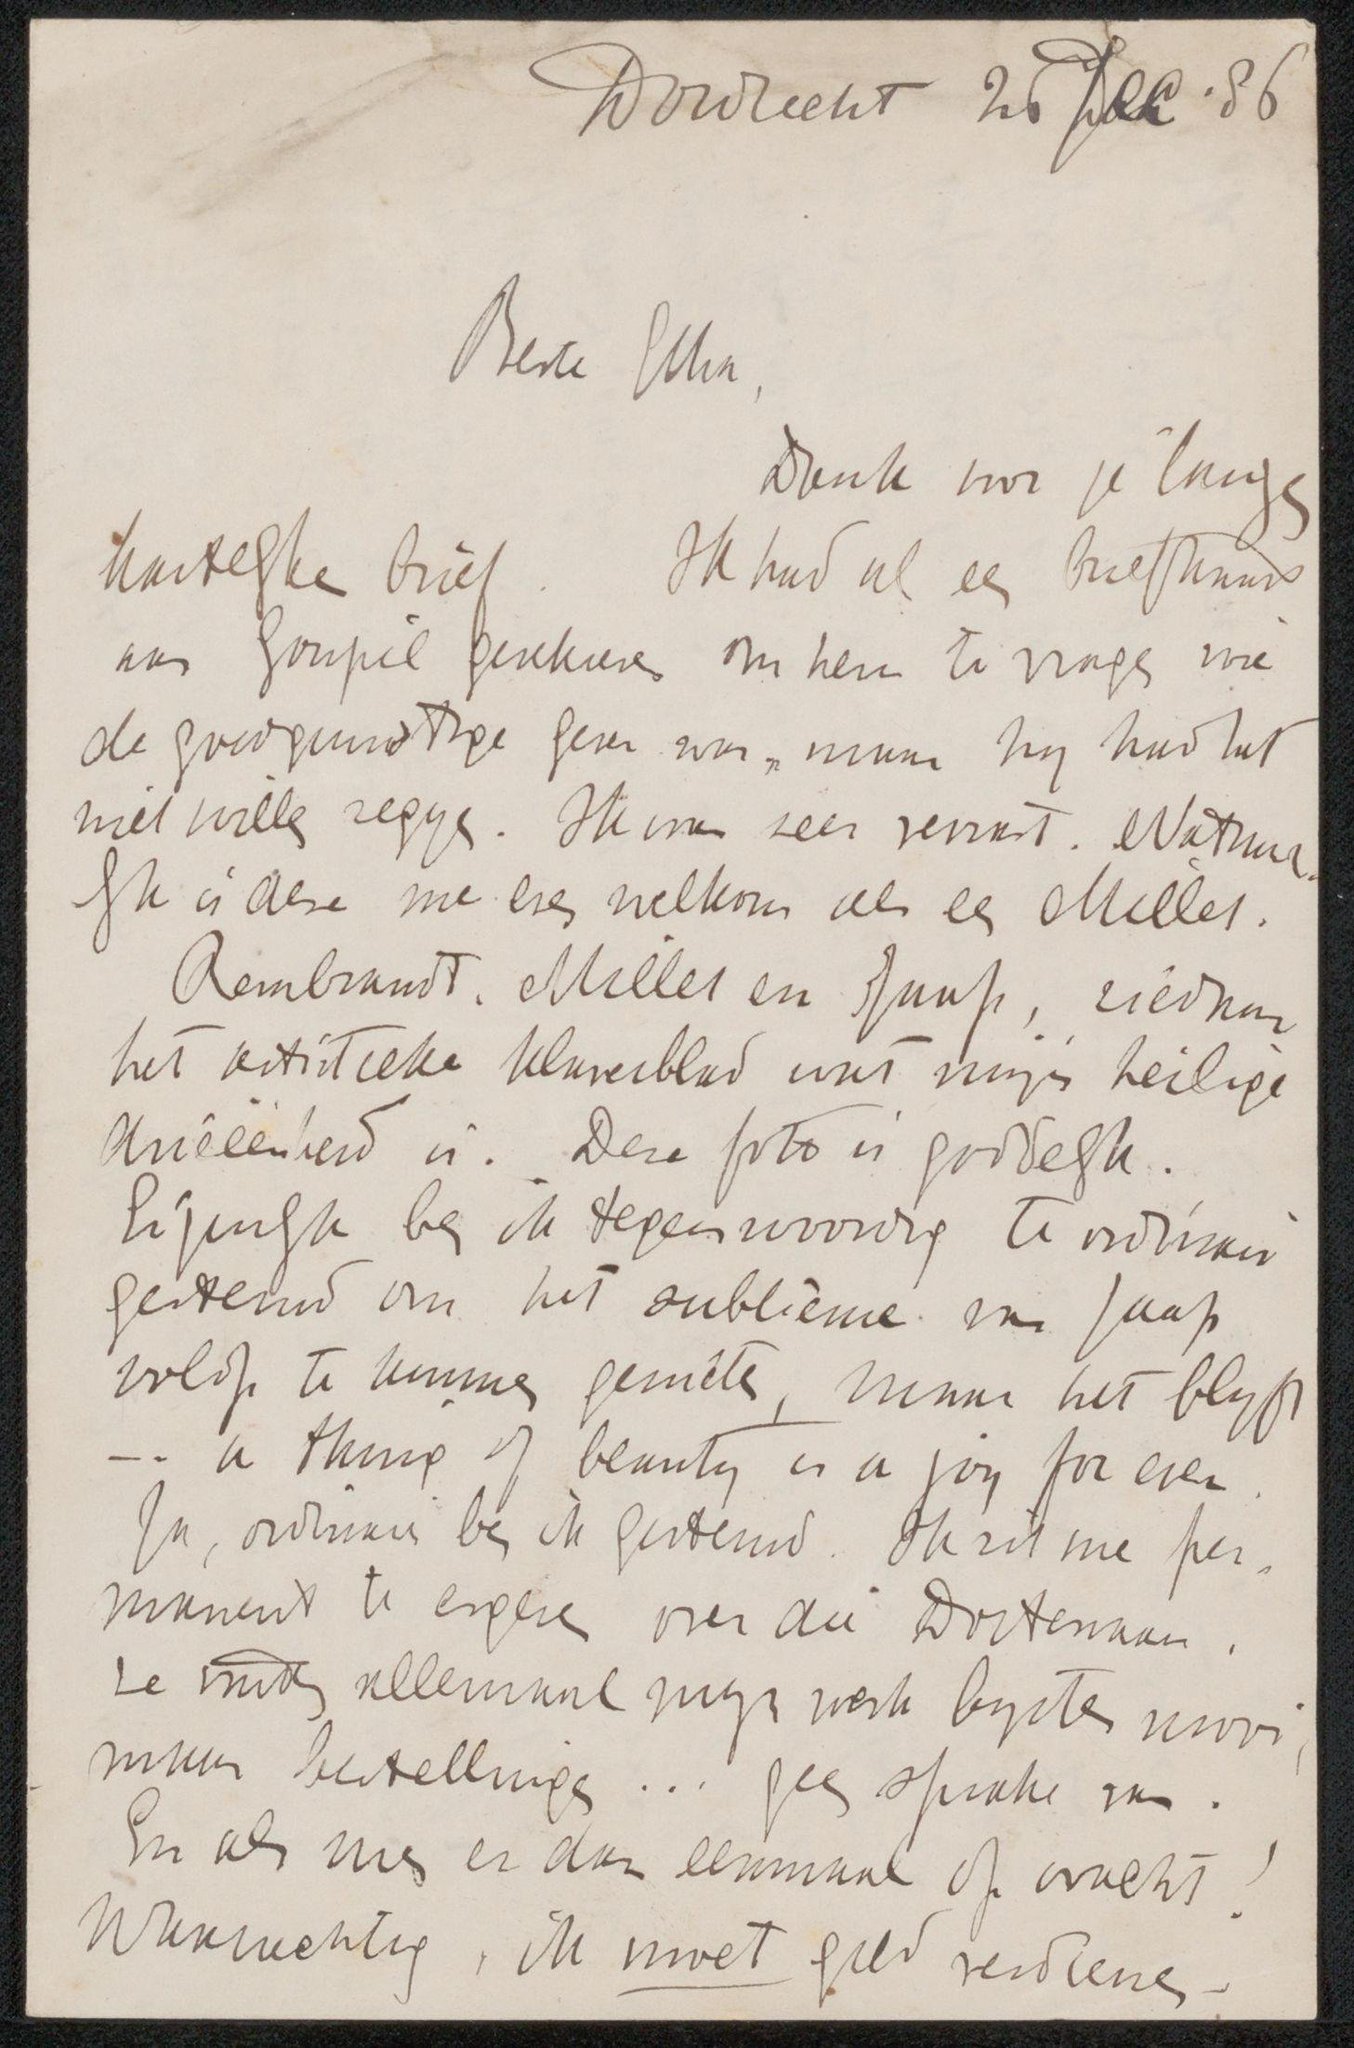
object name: letter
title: Brief aan Etha Fles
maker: jan veth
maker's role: designer, draughtsman, painter, print maker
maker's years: 1864-1925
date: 1886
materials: ink, paper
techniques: pen, writing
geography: dordrecht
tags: thérèse schwartze, the hague, jacob maris, jean françois millet, etha fles, leiden, rembrandt van rijn, printer, the graphic arts, painting (including book-illumination, miniature-painting), exhibition ~ art, historical persons (portraits and scenes from the life), money, dordrecht, utrecht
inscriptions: collector's mark: ‘RPK’